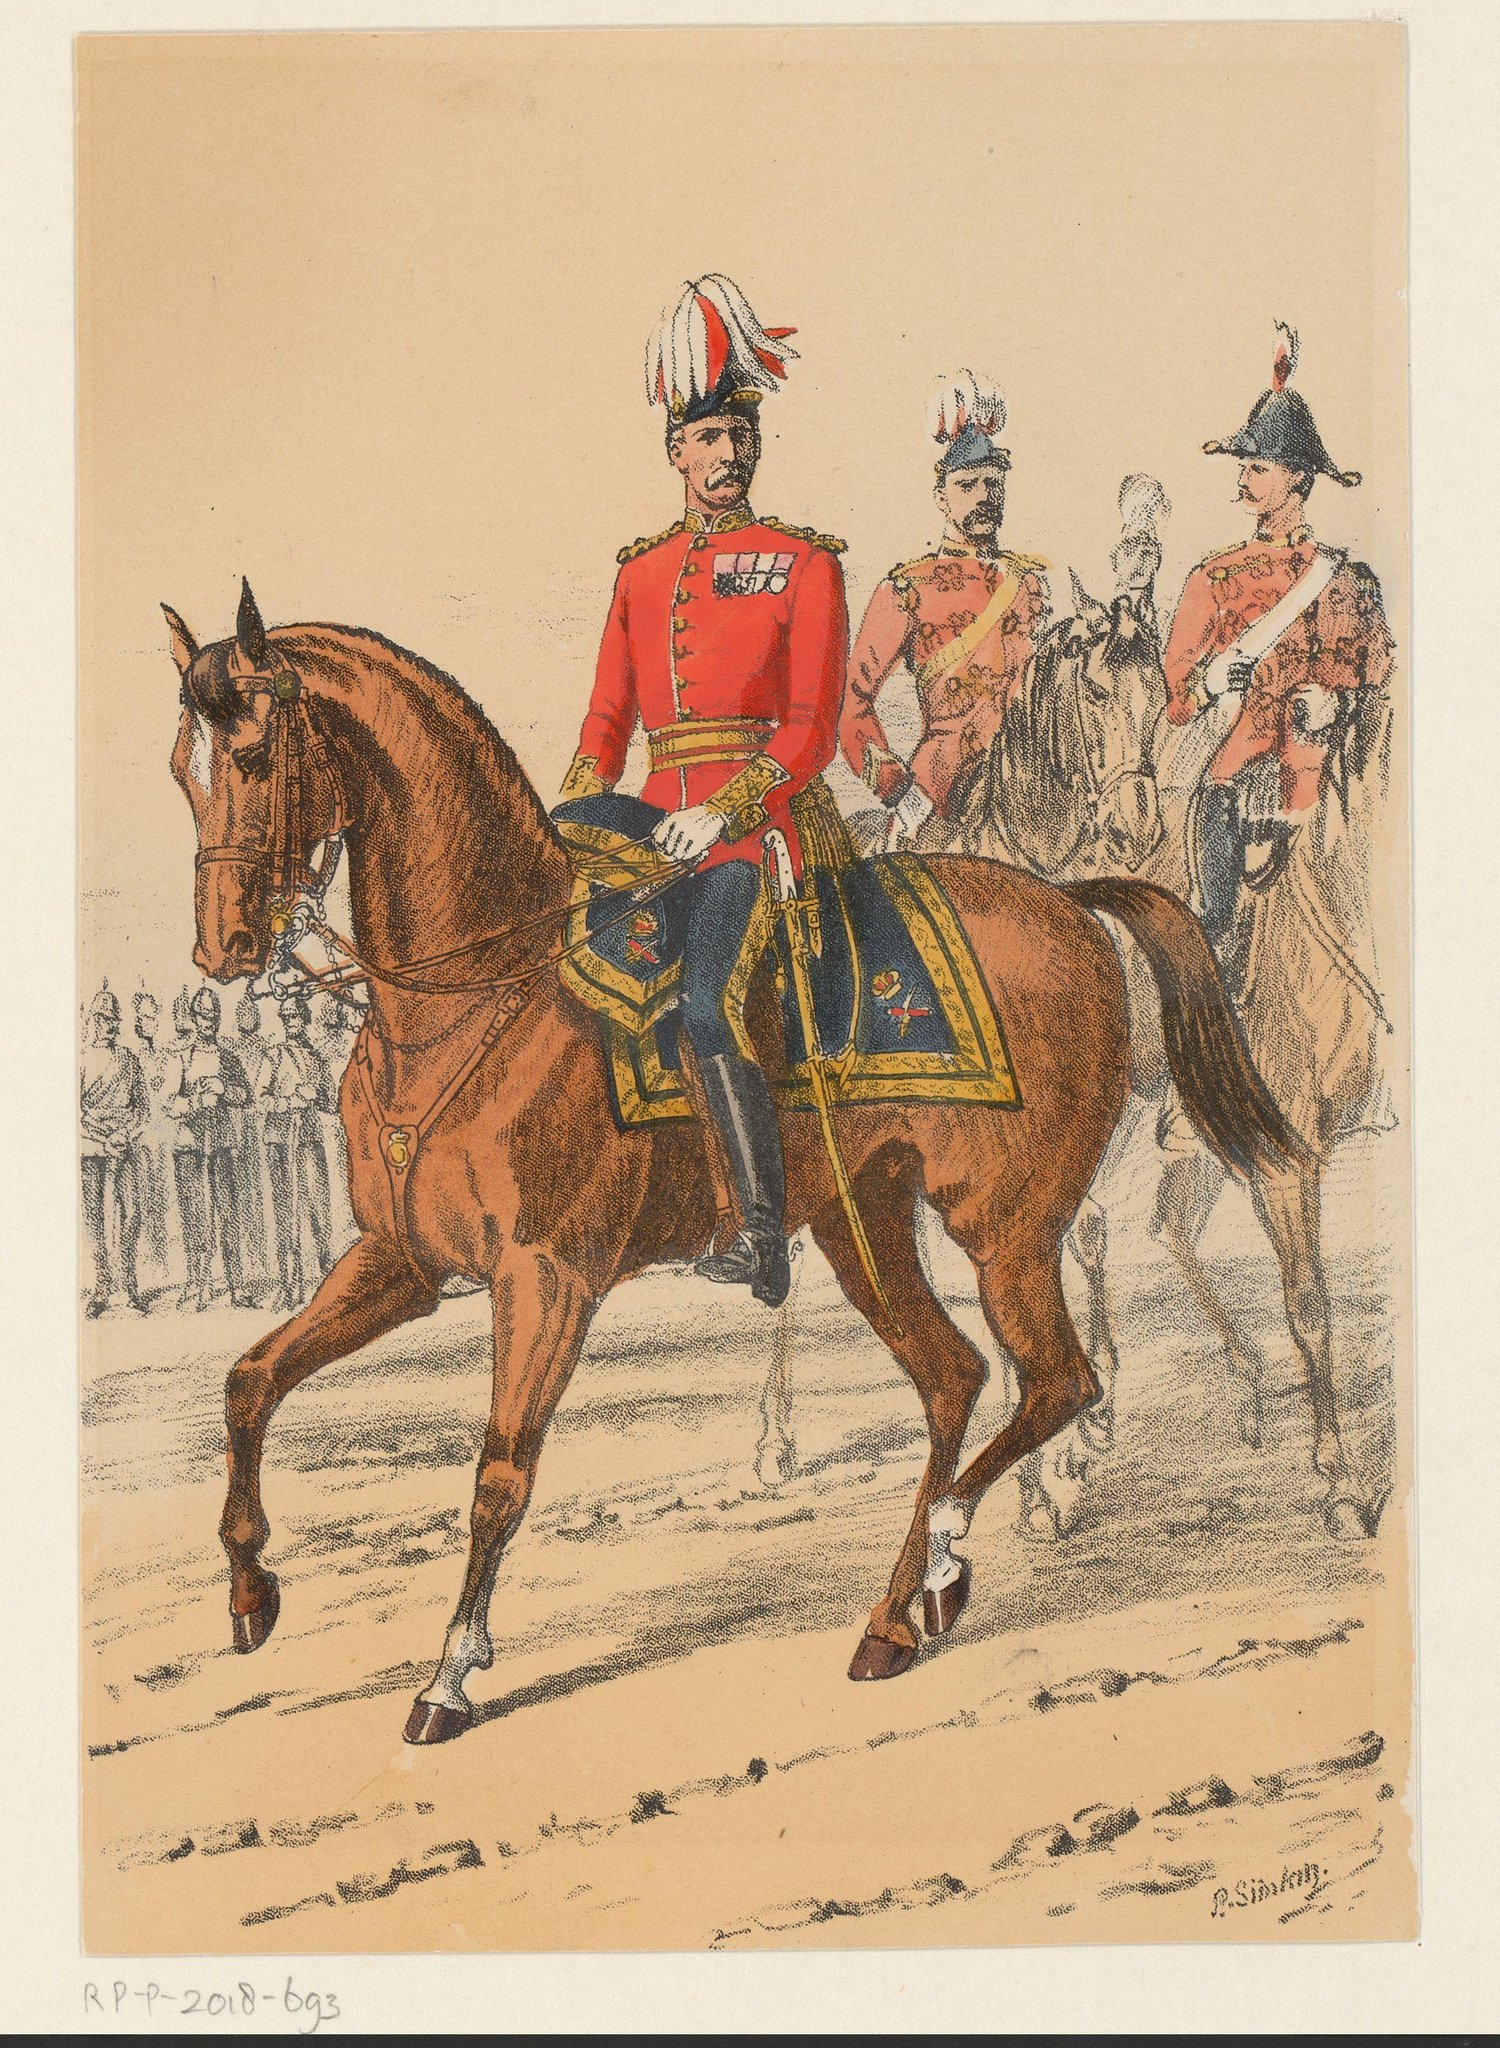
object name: print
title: Britse militair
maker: richard simkin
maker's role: draughtsman, painter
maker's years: 1840-1926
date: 1875-1925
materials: lacquer, paper, watercolor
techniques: hand coloring, lacquer, lithograph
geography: england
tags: (military) uniforms, great britain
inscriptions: collector's mark: Lugt 2228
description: Een Britse militaire bevelhebber te paard, naar links. Onderdeel van een serie van negen voorstellingen van Britse militaire uniformen.